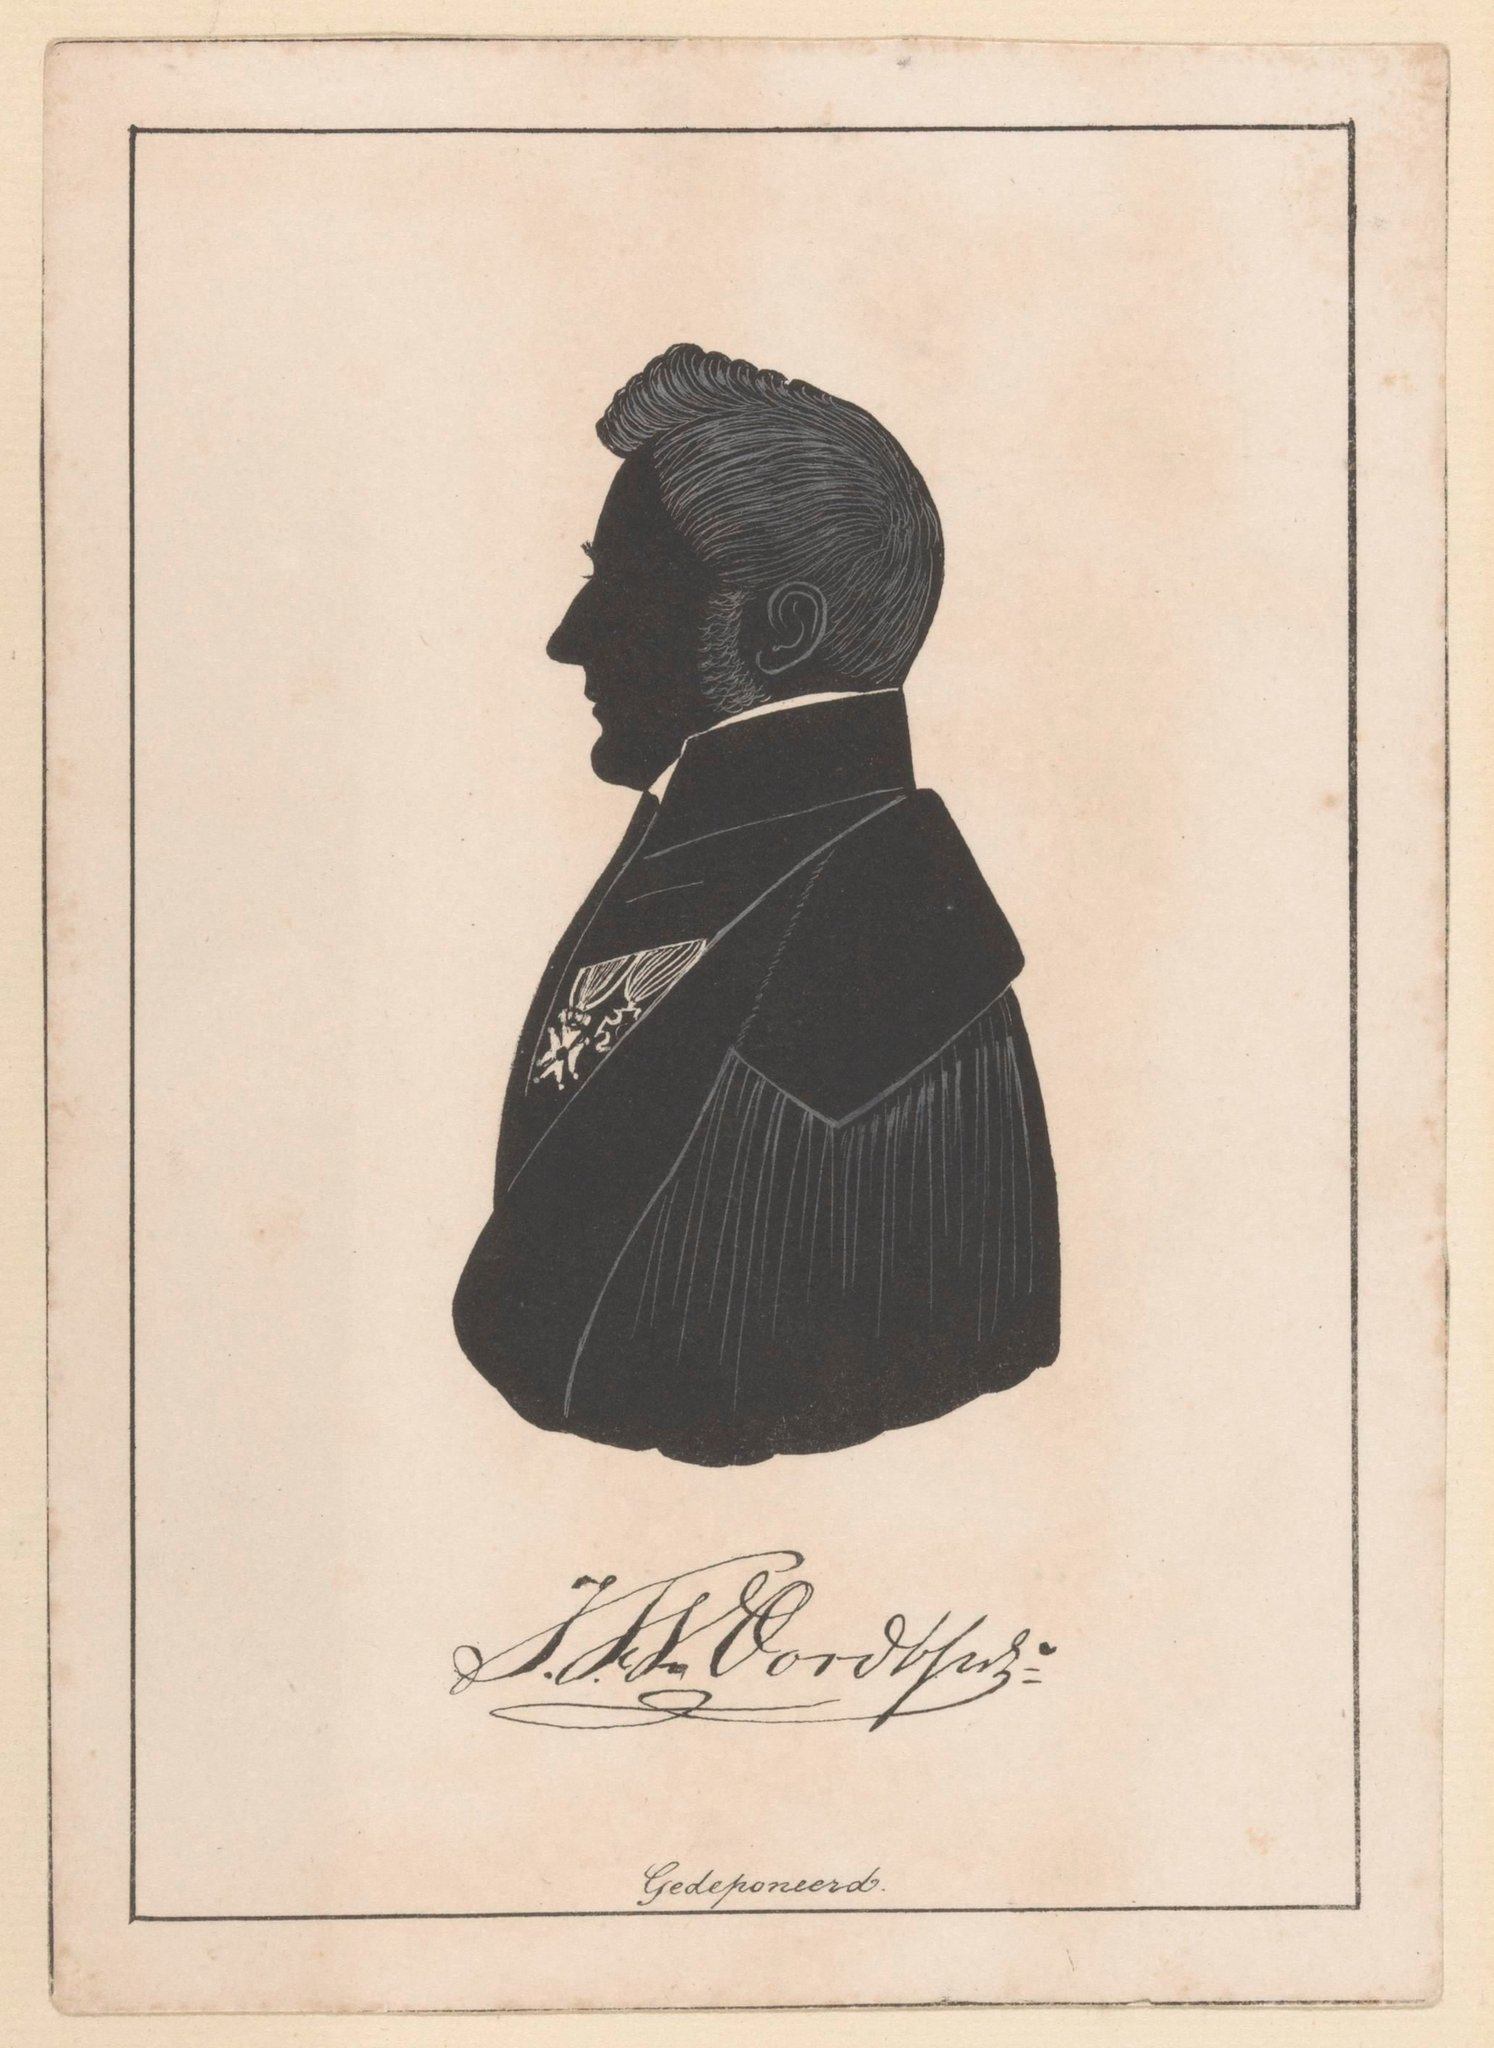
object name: print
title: Silhouetportret van onbekende man met twee onderscheidingen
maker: pieter barbiers (iv)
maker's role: painter, print maker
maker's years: 1798-1848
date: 1809-1848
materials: paper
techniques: hand coloring, lithograph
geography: netherlands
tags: historical persons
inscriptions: : ‘Gedeponeerd.’, collector's mark: Lugt 2228, watermark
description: Onder het portret de signatuur van de geportretteerde (slecht leesbaar).